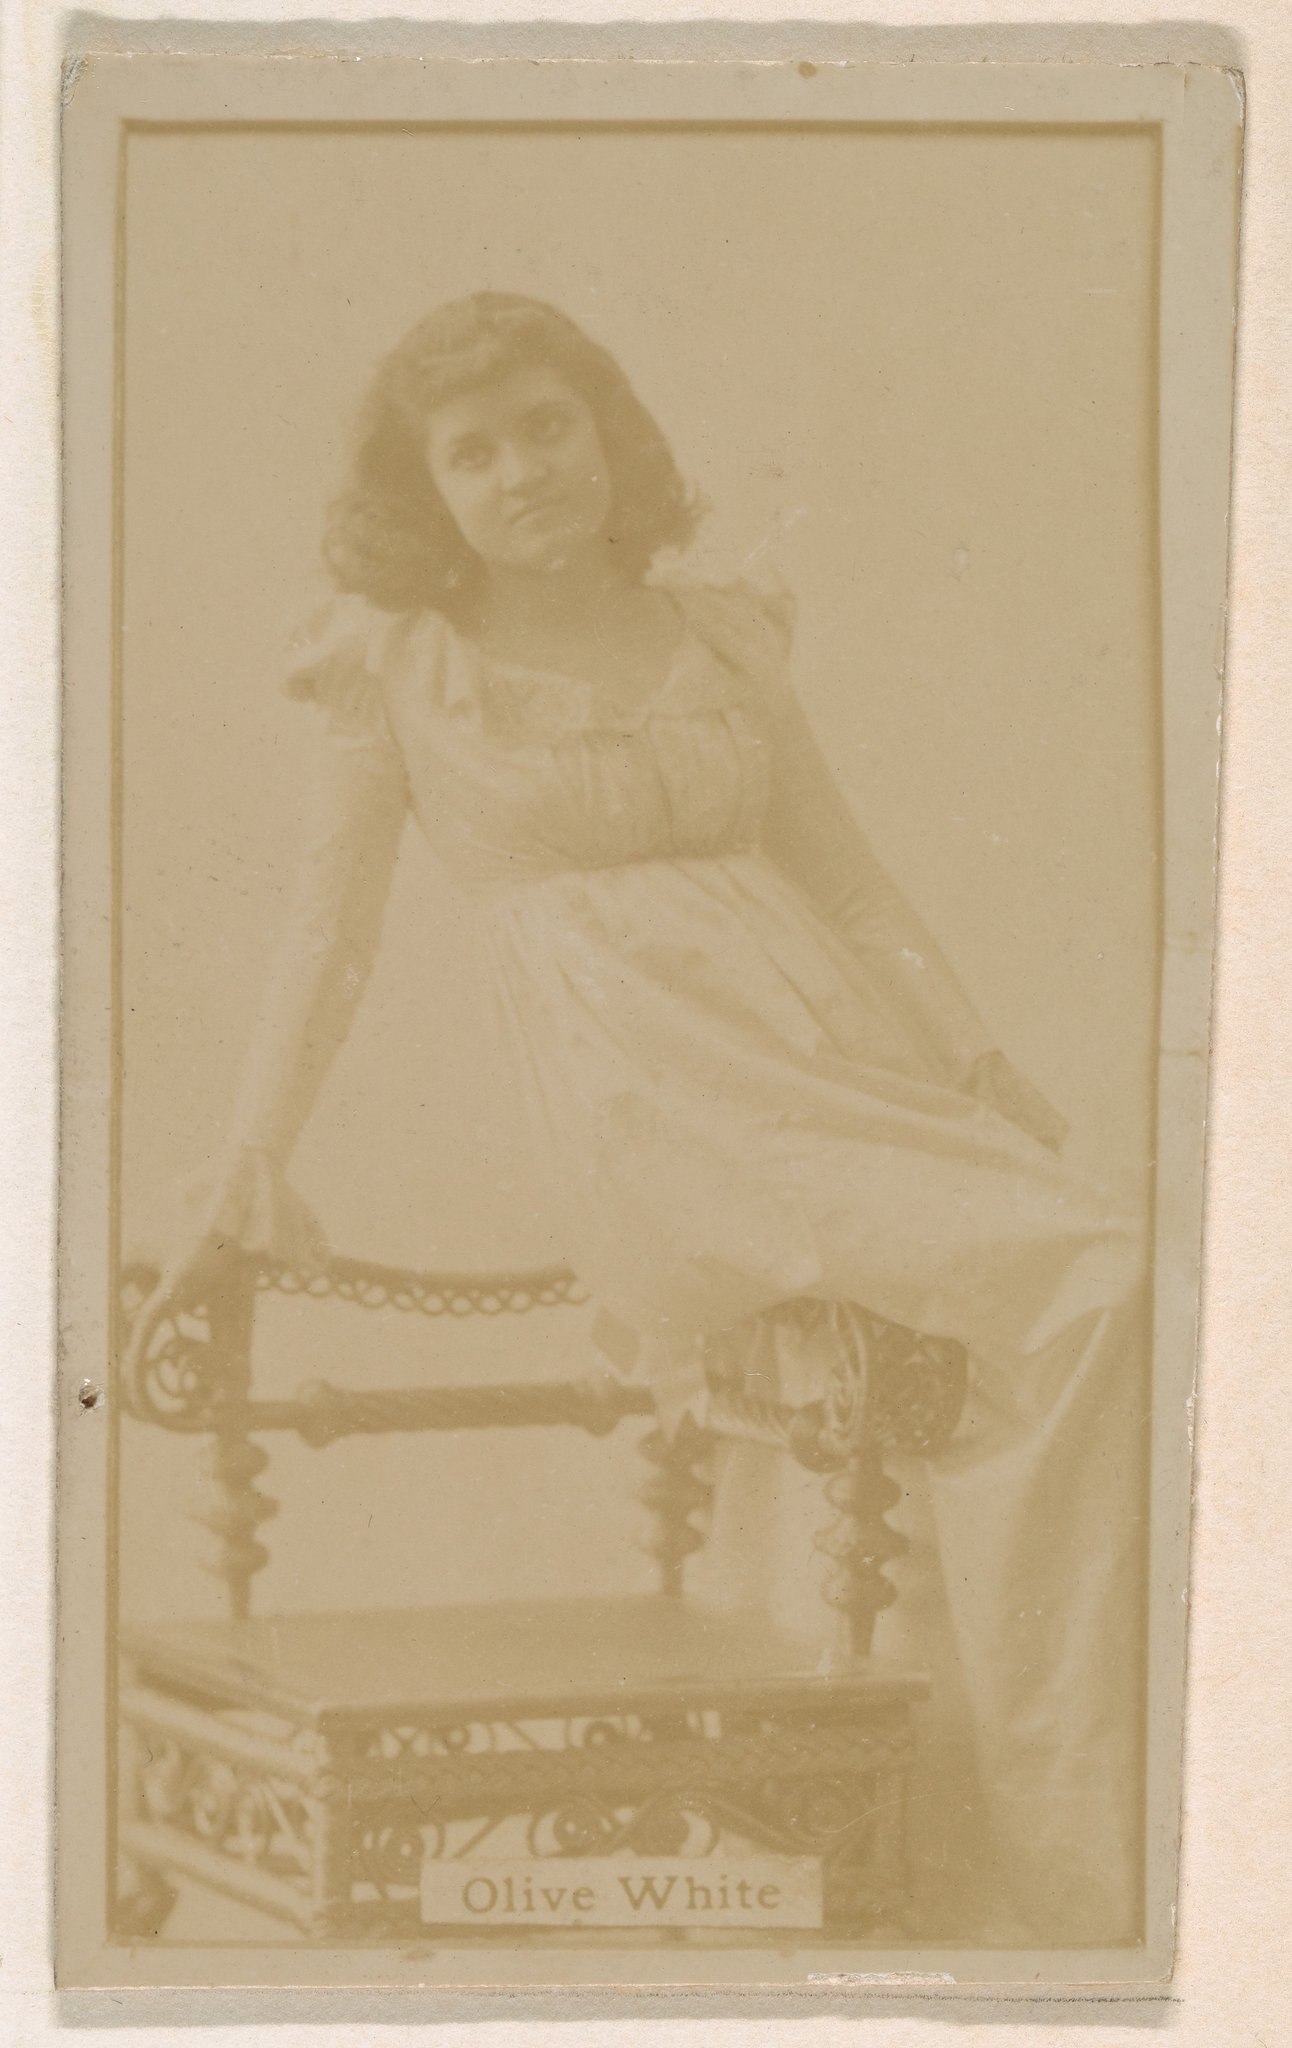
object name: photograph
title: Olive White, from the Actresses series (N245) issued by Kinney Brothers to promote Sweet Caporal Cigarettes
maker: kinney brothers tobacco company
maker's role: publisher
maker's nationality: american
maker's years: 1869-2011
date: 1890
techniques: albumen silver print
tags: portraits,women,actresses